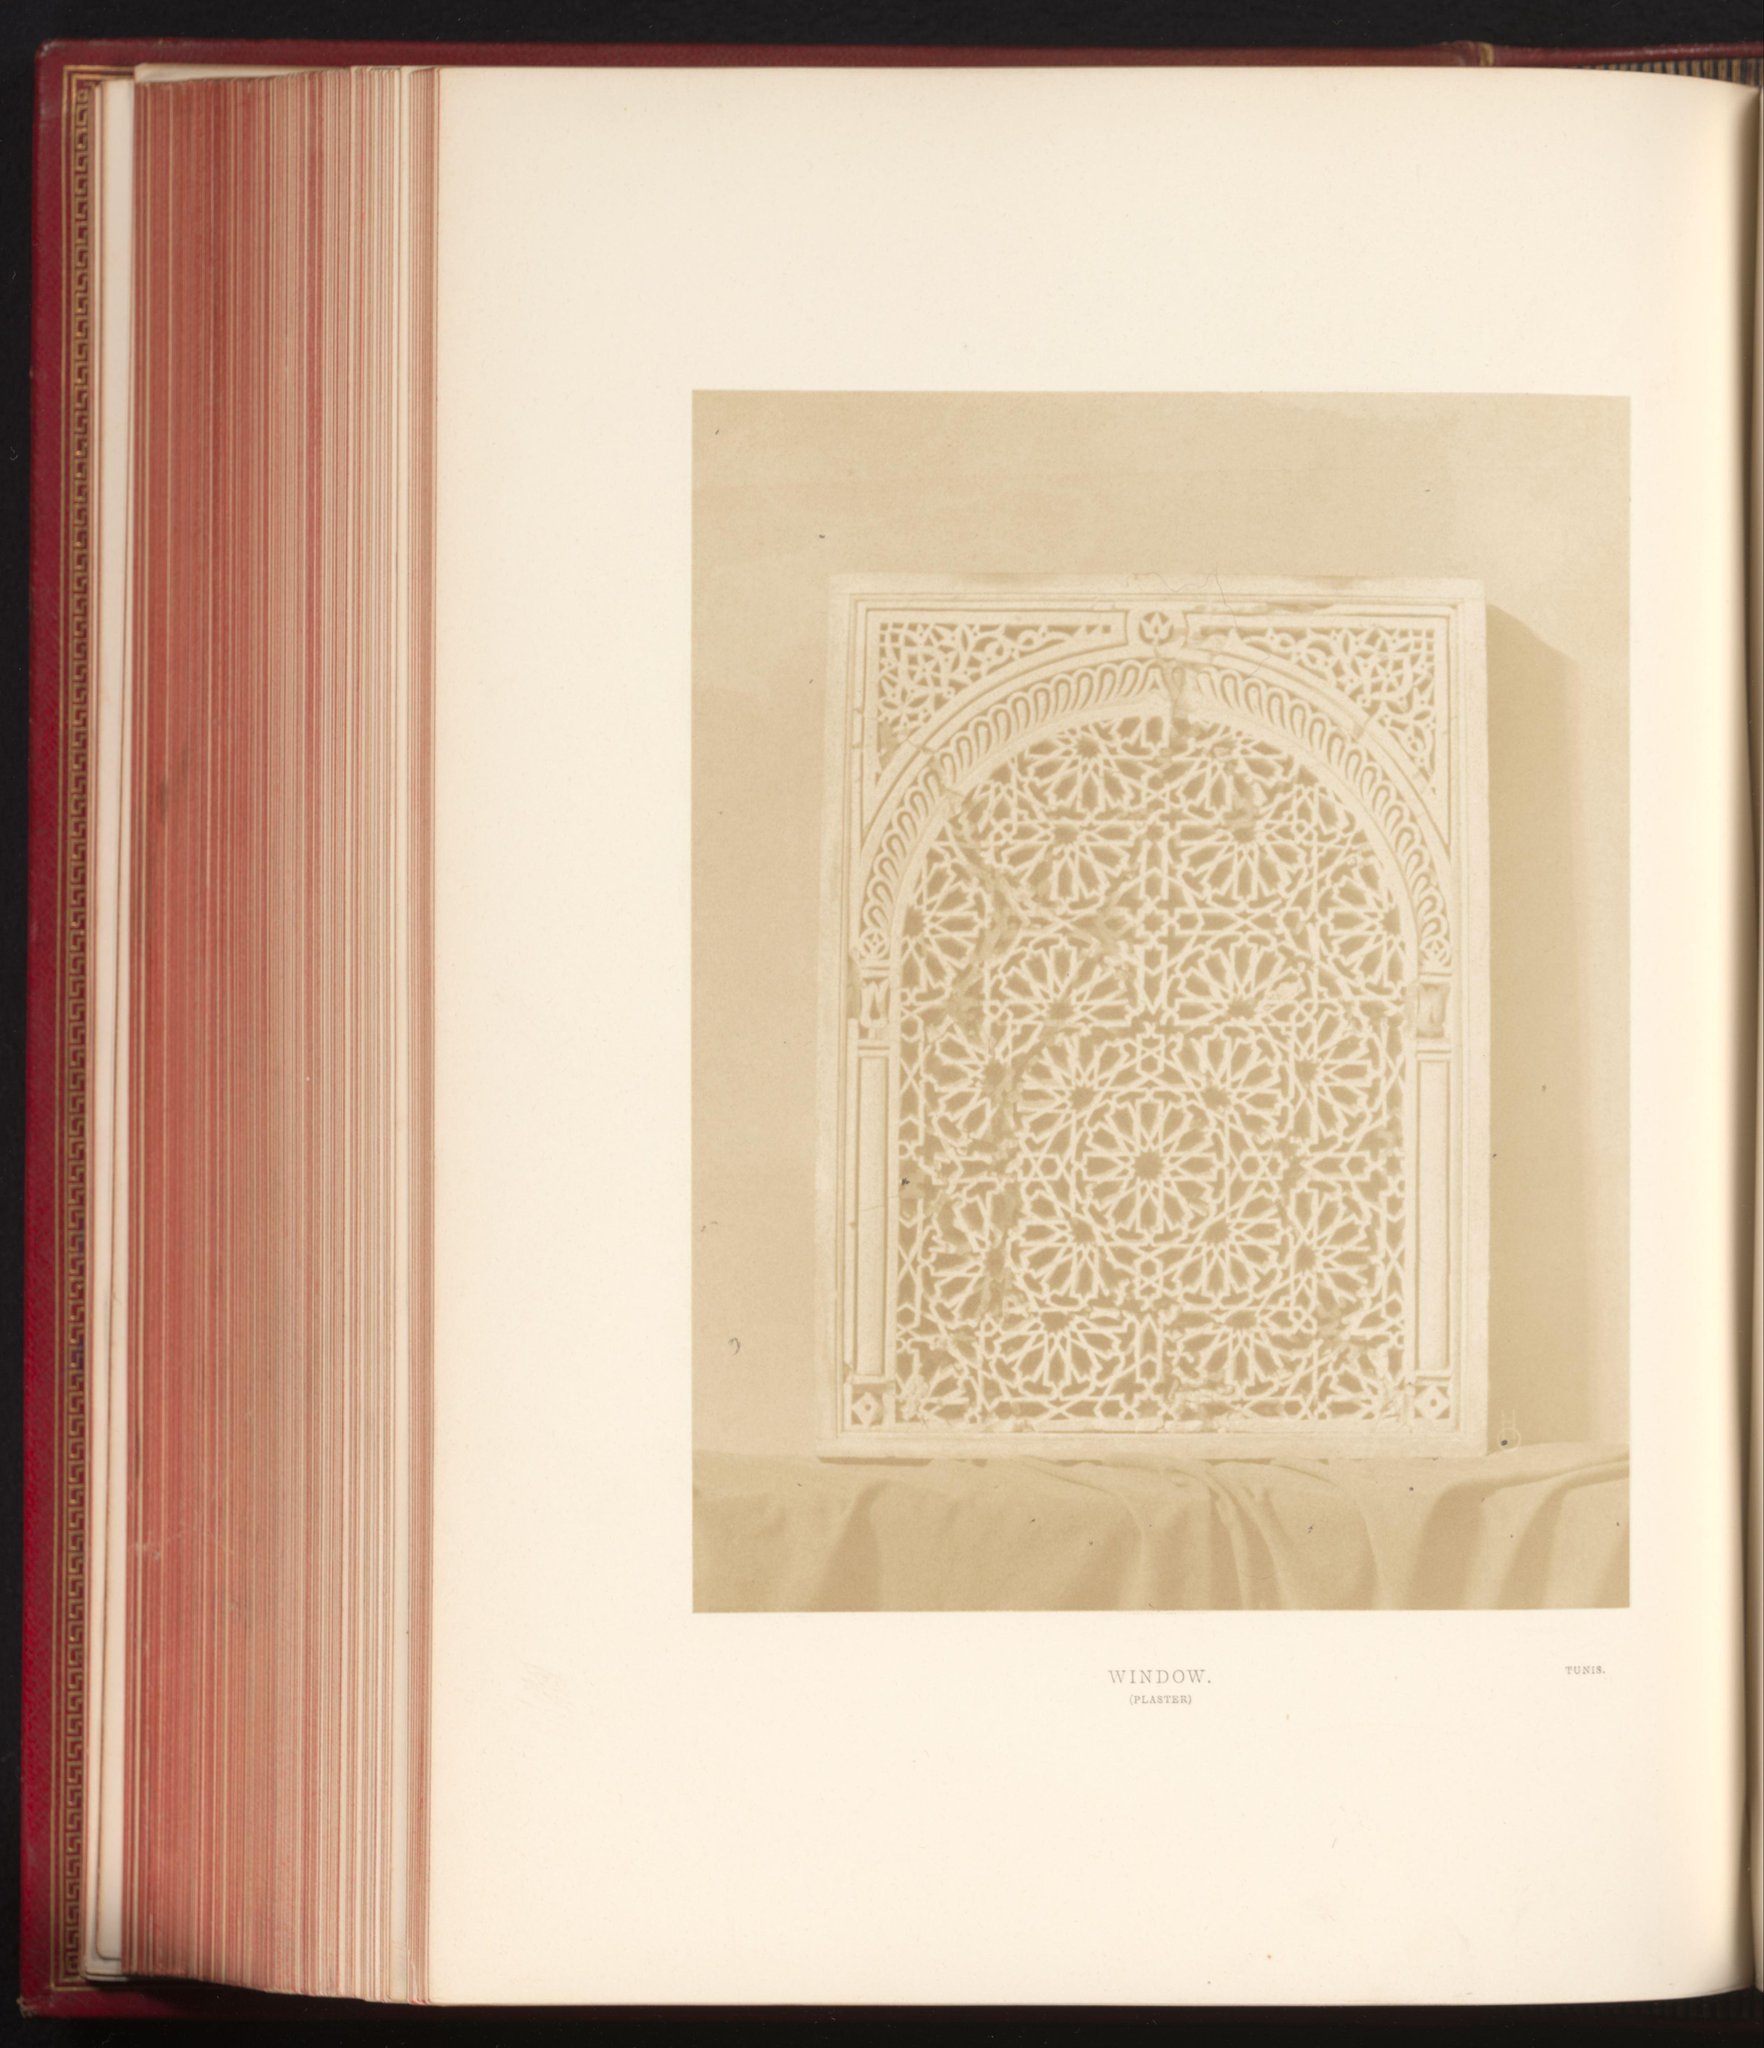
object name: page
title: Raam gedecoreerd met geometrische patronen uit Tunesië tentoongesteld op de Great Exhibition of the Works of Industry of All Nations van 1851 in Londen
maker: hugh owen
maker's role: fotograaf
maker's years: 1808-1897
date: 1851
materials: photographic support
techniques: salted paper print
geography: london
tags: window, london